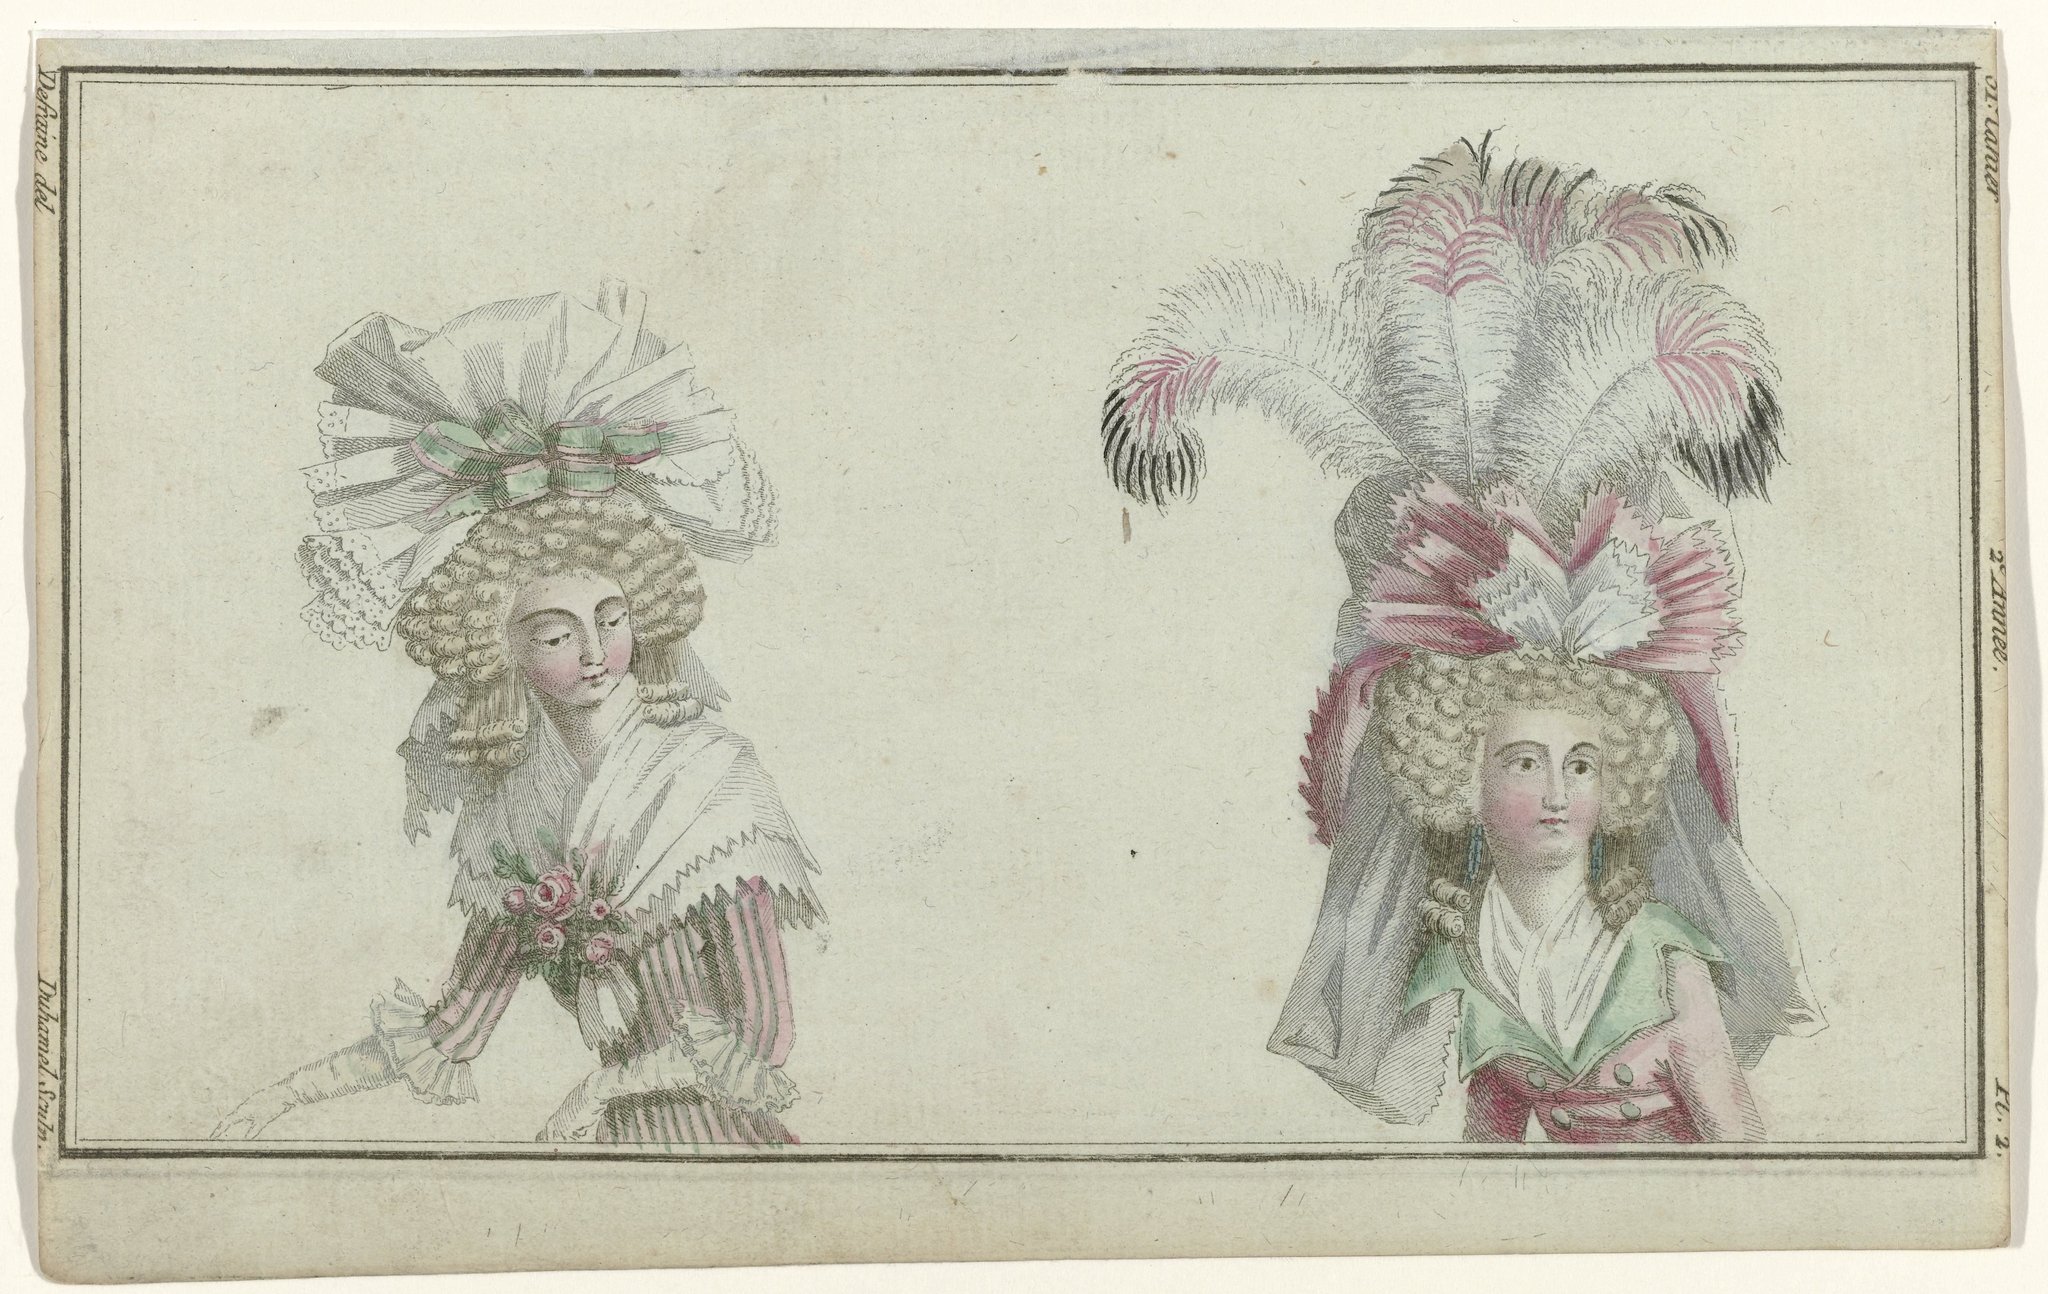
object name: fashion print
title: Magasin des Modes Nouvelles Françaises et Anglaises, 20 septembre 1787, Pl. 2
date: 1787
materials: paper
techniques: engraving, hand coloring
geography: paris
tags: clothing for the upper part of the body (+ women's clothes), ear-rings (+ women's clothes), cut flowers; nosegay, bunch of flowers, head-gear: cap (+ women's clothes), fashion plates, gloves, mittens, etc. (+ women's clothes), piece of clothing covering the breast or décolleté (fichu) (+ women's clothes)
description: Twee vrouwenbustes met op het gekrulde haar een muts: waaiervormige muts of demi-bonnet à l'éventail (links) en een grote roze muts met witte veren (rechts). De prent maakt deel uit van het 31e Cahier, 2e année, uit de serie Magasin des Modes Nouvelles Françaises et Anglaises. De serie bestaat uit 172 modeprenten, uitgegeven door Buisson, Parijs, 20 novembre 1786 - 21 décembre 1789.